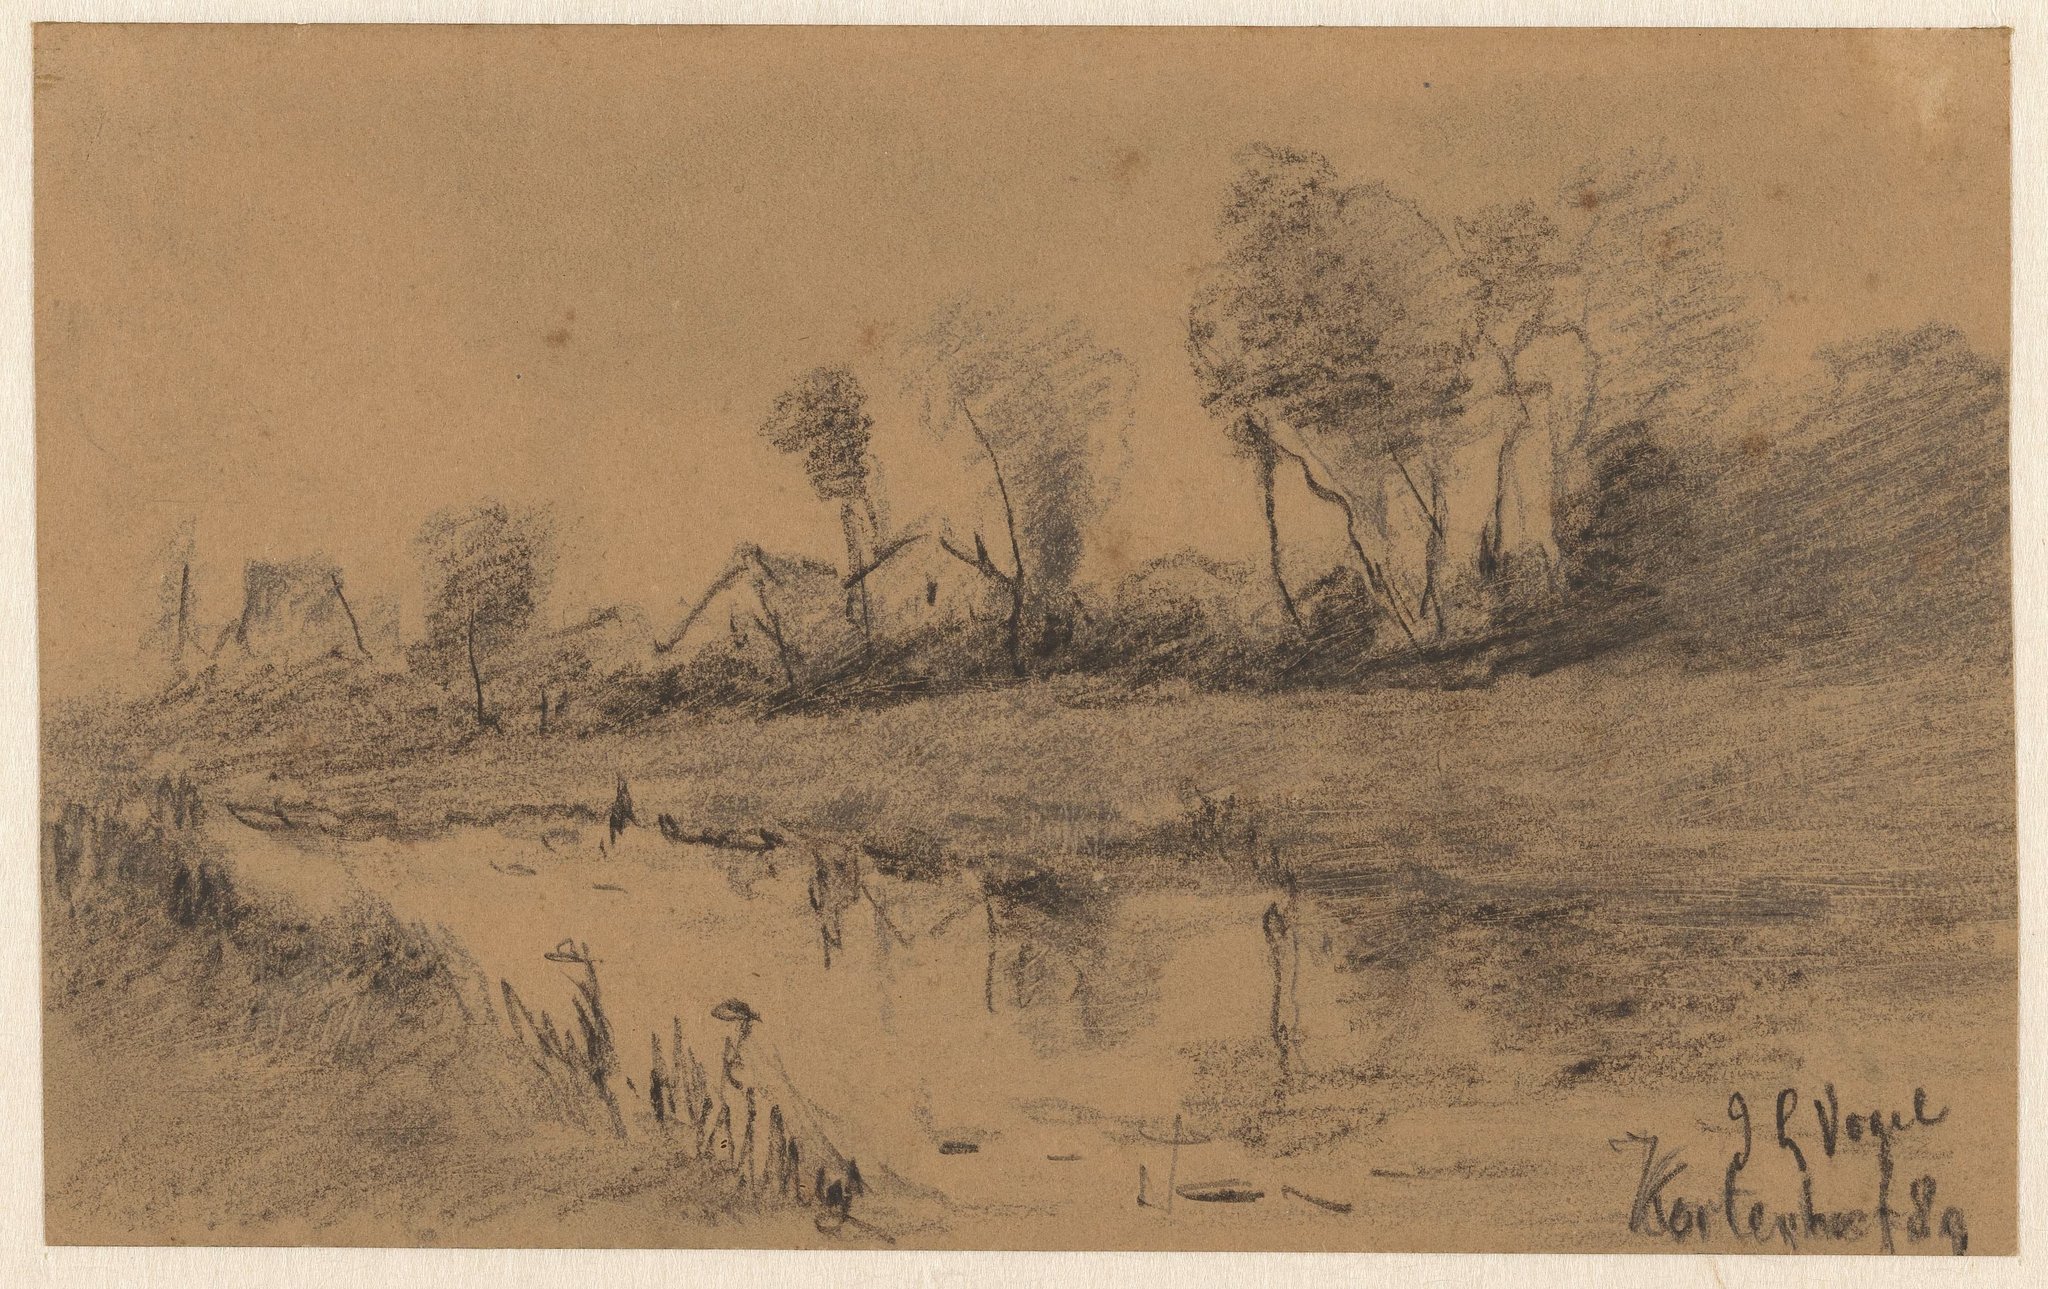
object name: drawing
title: Water bij Kortenhoef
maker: johannes gijsbert vogel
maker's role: draughtsman, painter, print maker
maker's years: 1828-1915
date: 1889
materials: chalk, paper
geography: kortenhoef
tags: landscapes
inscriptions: date